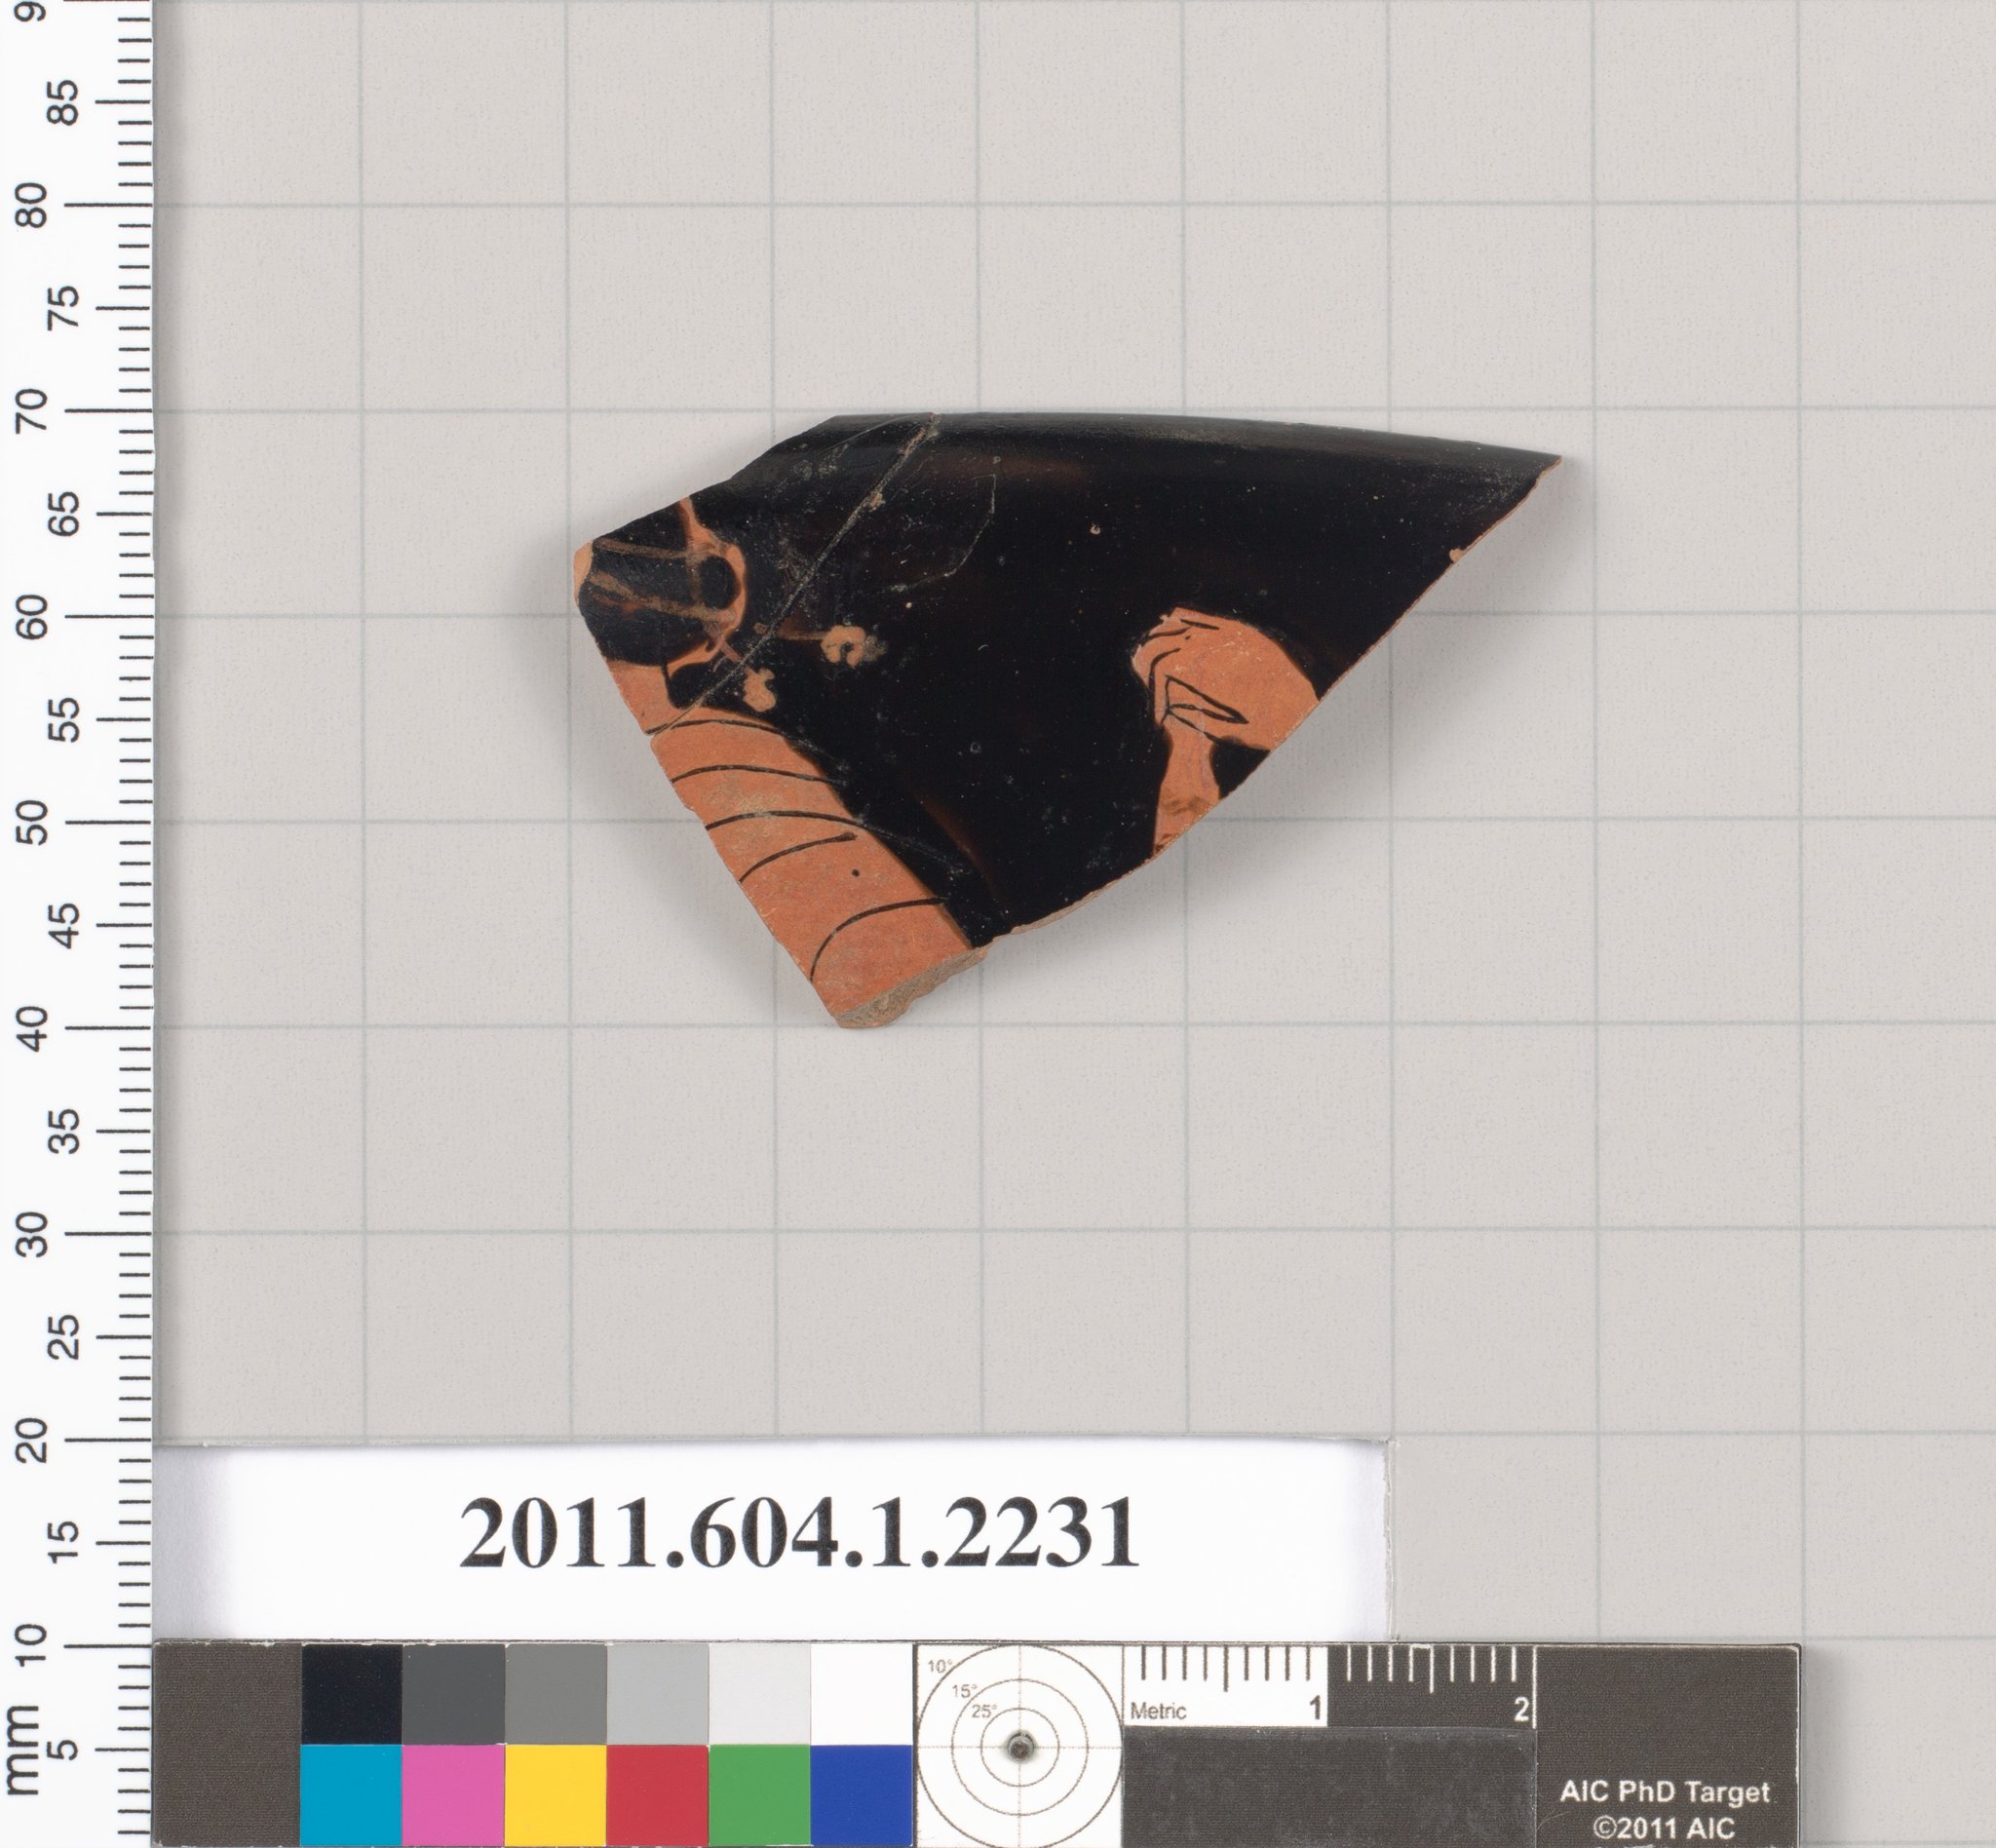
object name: kylix fragment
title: Terracotta rim fragment of a kylix (drinking cup)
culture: greek, attic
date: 475-451 BCE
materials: terracotta